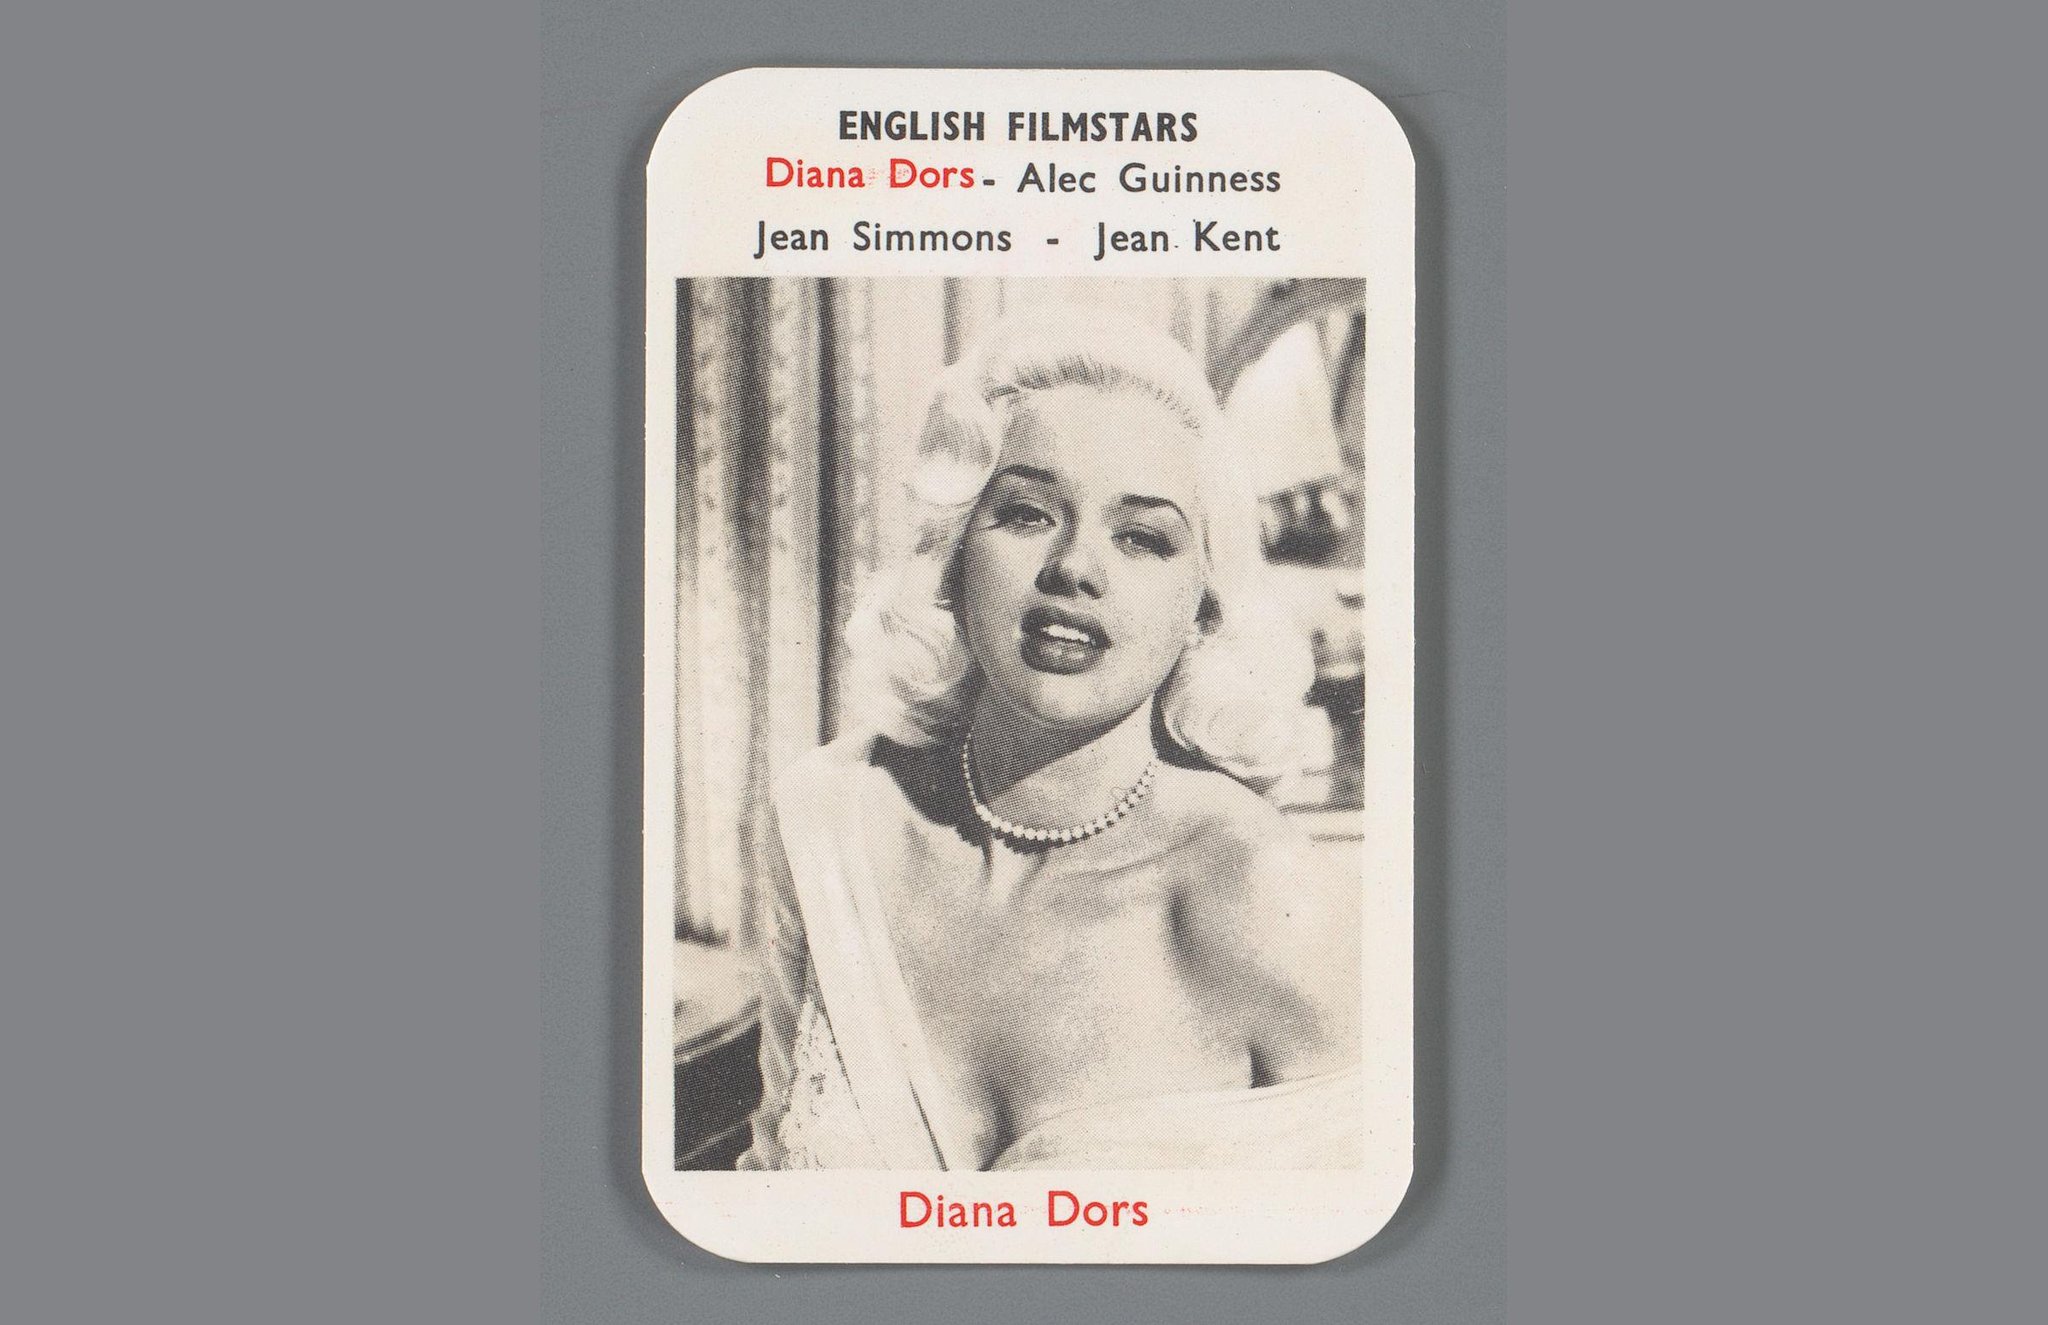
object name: playing card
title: English Filmstars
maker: Anonymous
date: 1960-1970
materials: paper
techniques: autotype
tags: portrait of actor, actress